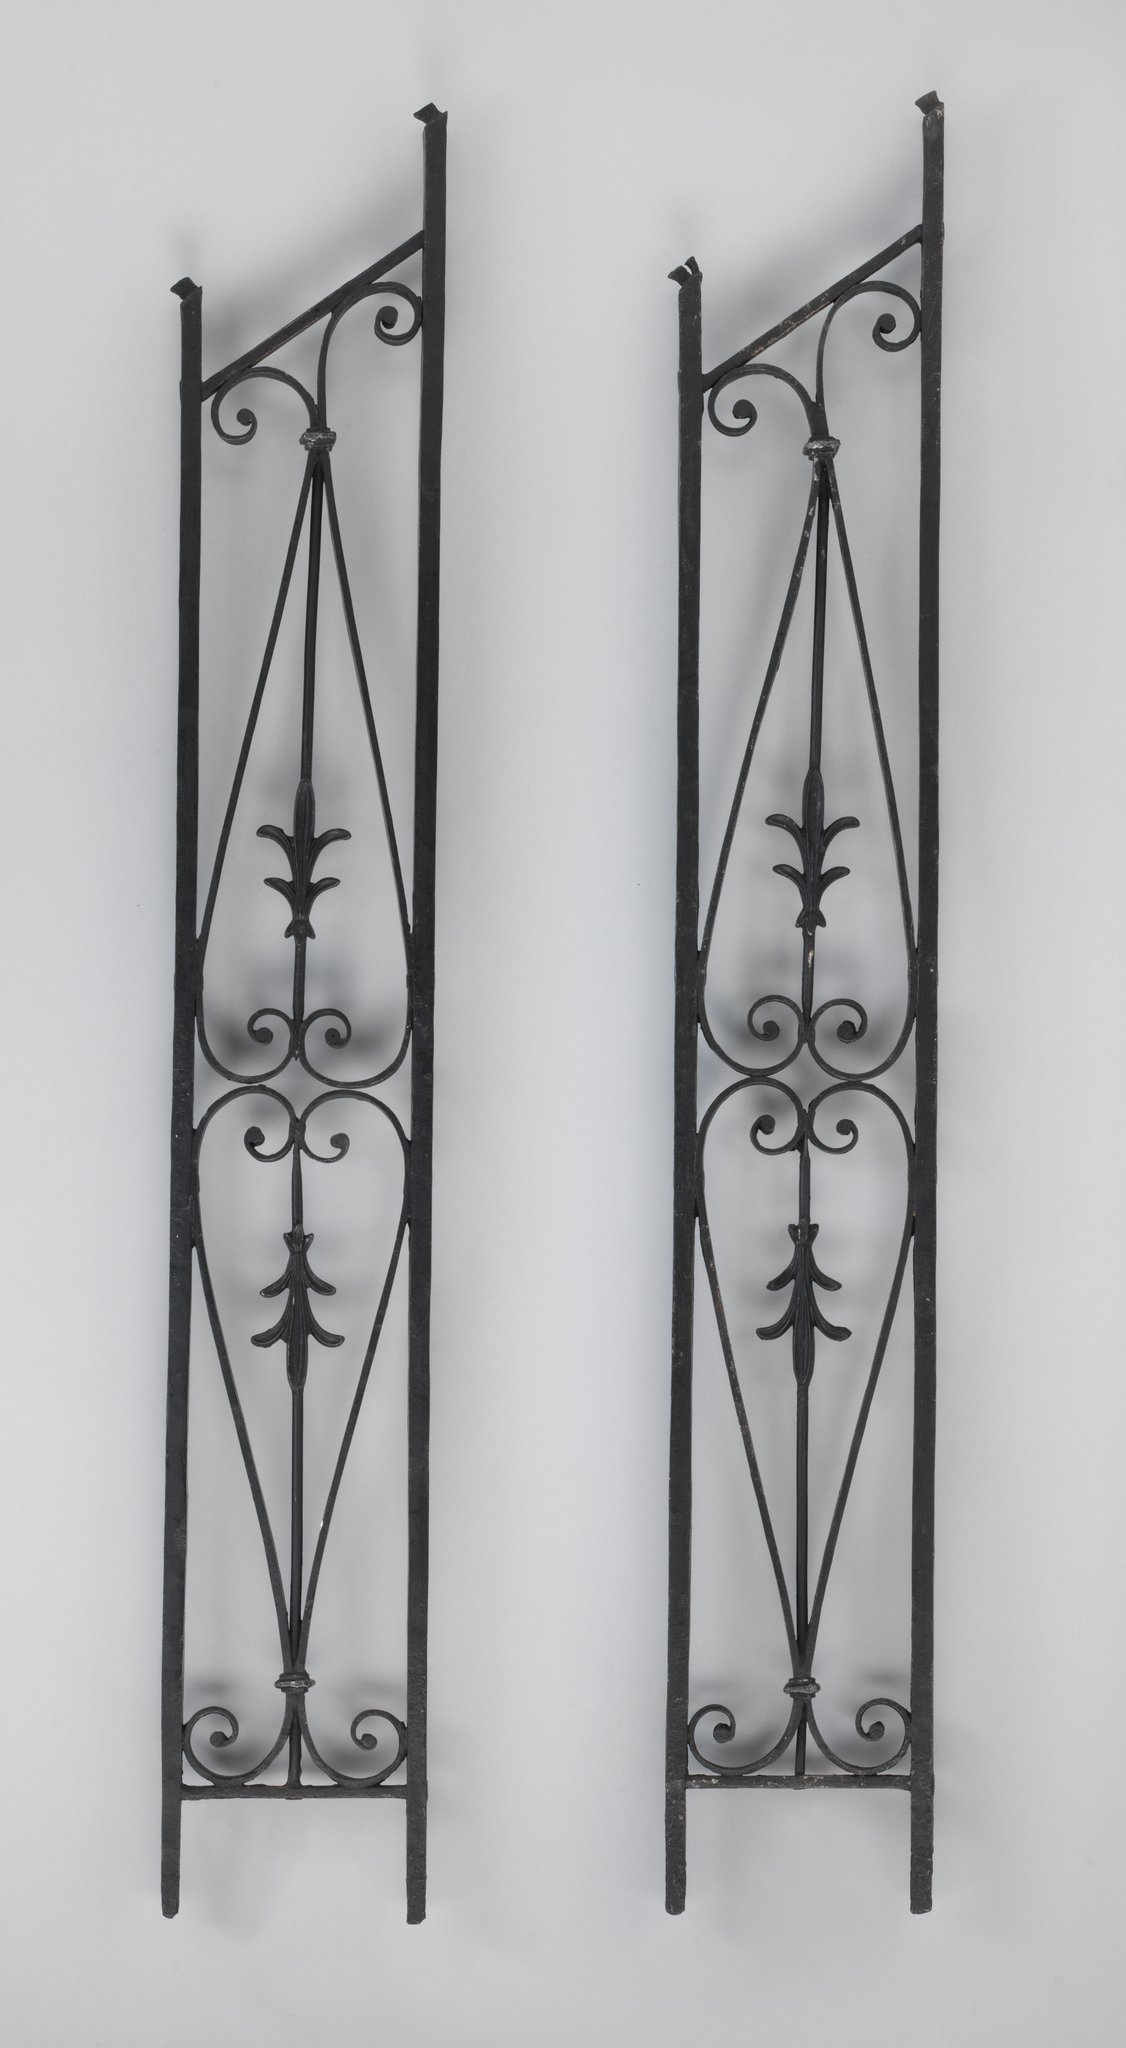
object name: baluster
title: Iron baluster (one of a pair)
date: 1780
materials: lead, iron